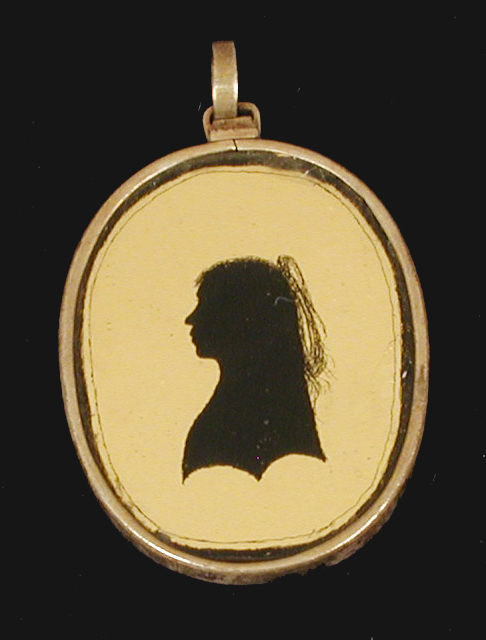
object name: locket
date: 1801-1833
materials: glass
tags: profiles,women